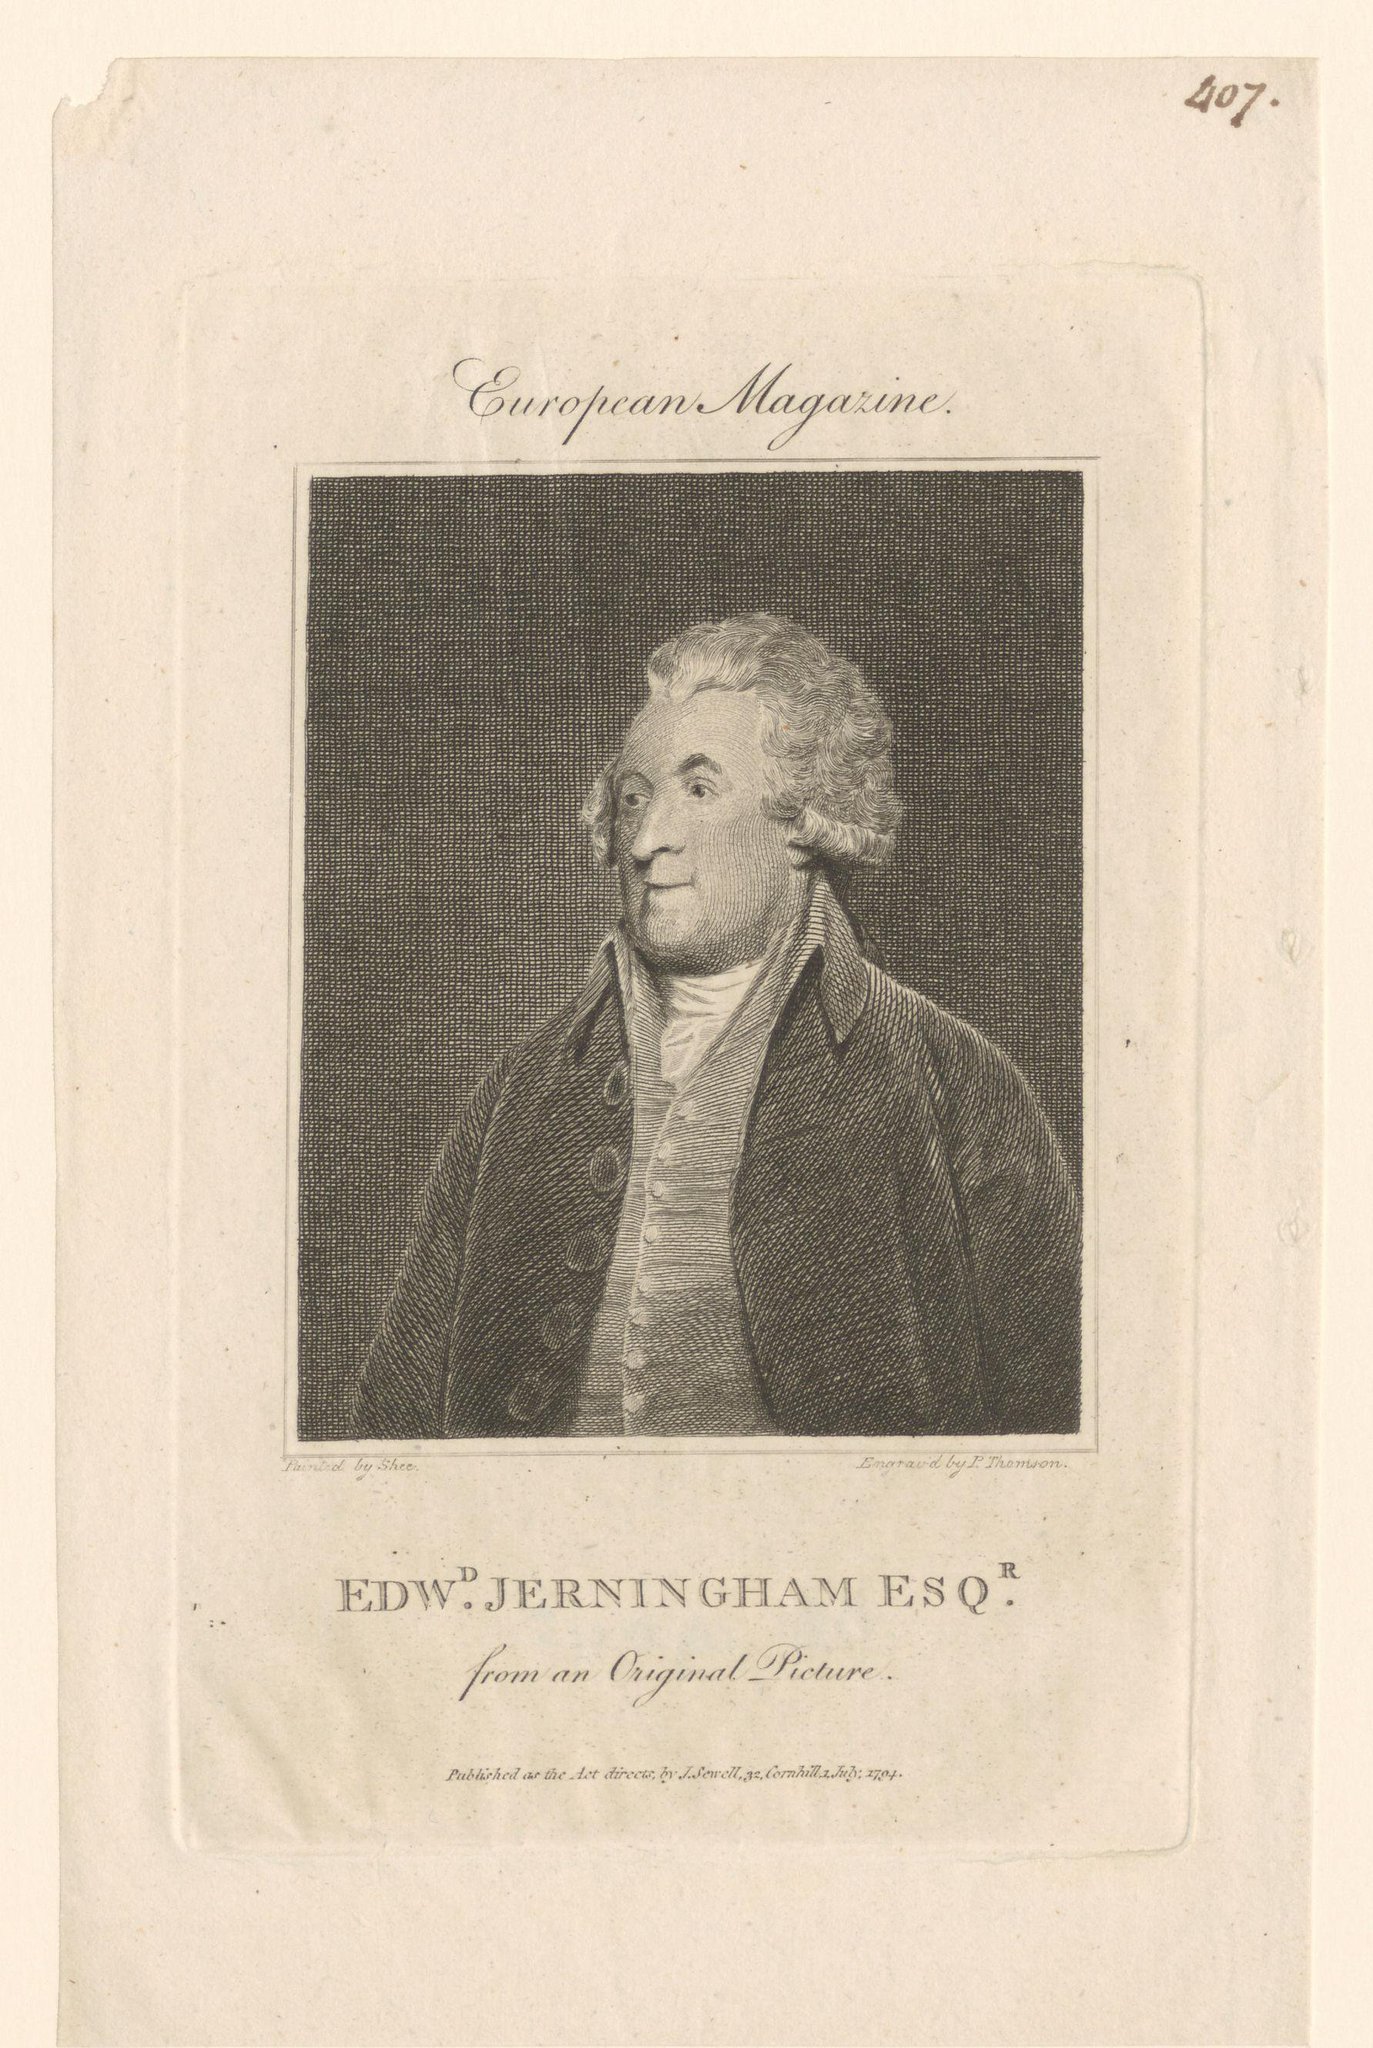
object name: print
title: Portret Edward Jerningham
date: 1707-1794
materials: paper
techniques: engraving, etching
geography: london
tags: historical persons, portrait of a writer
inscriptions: collector's mark: Lugt 2228